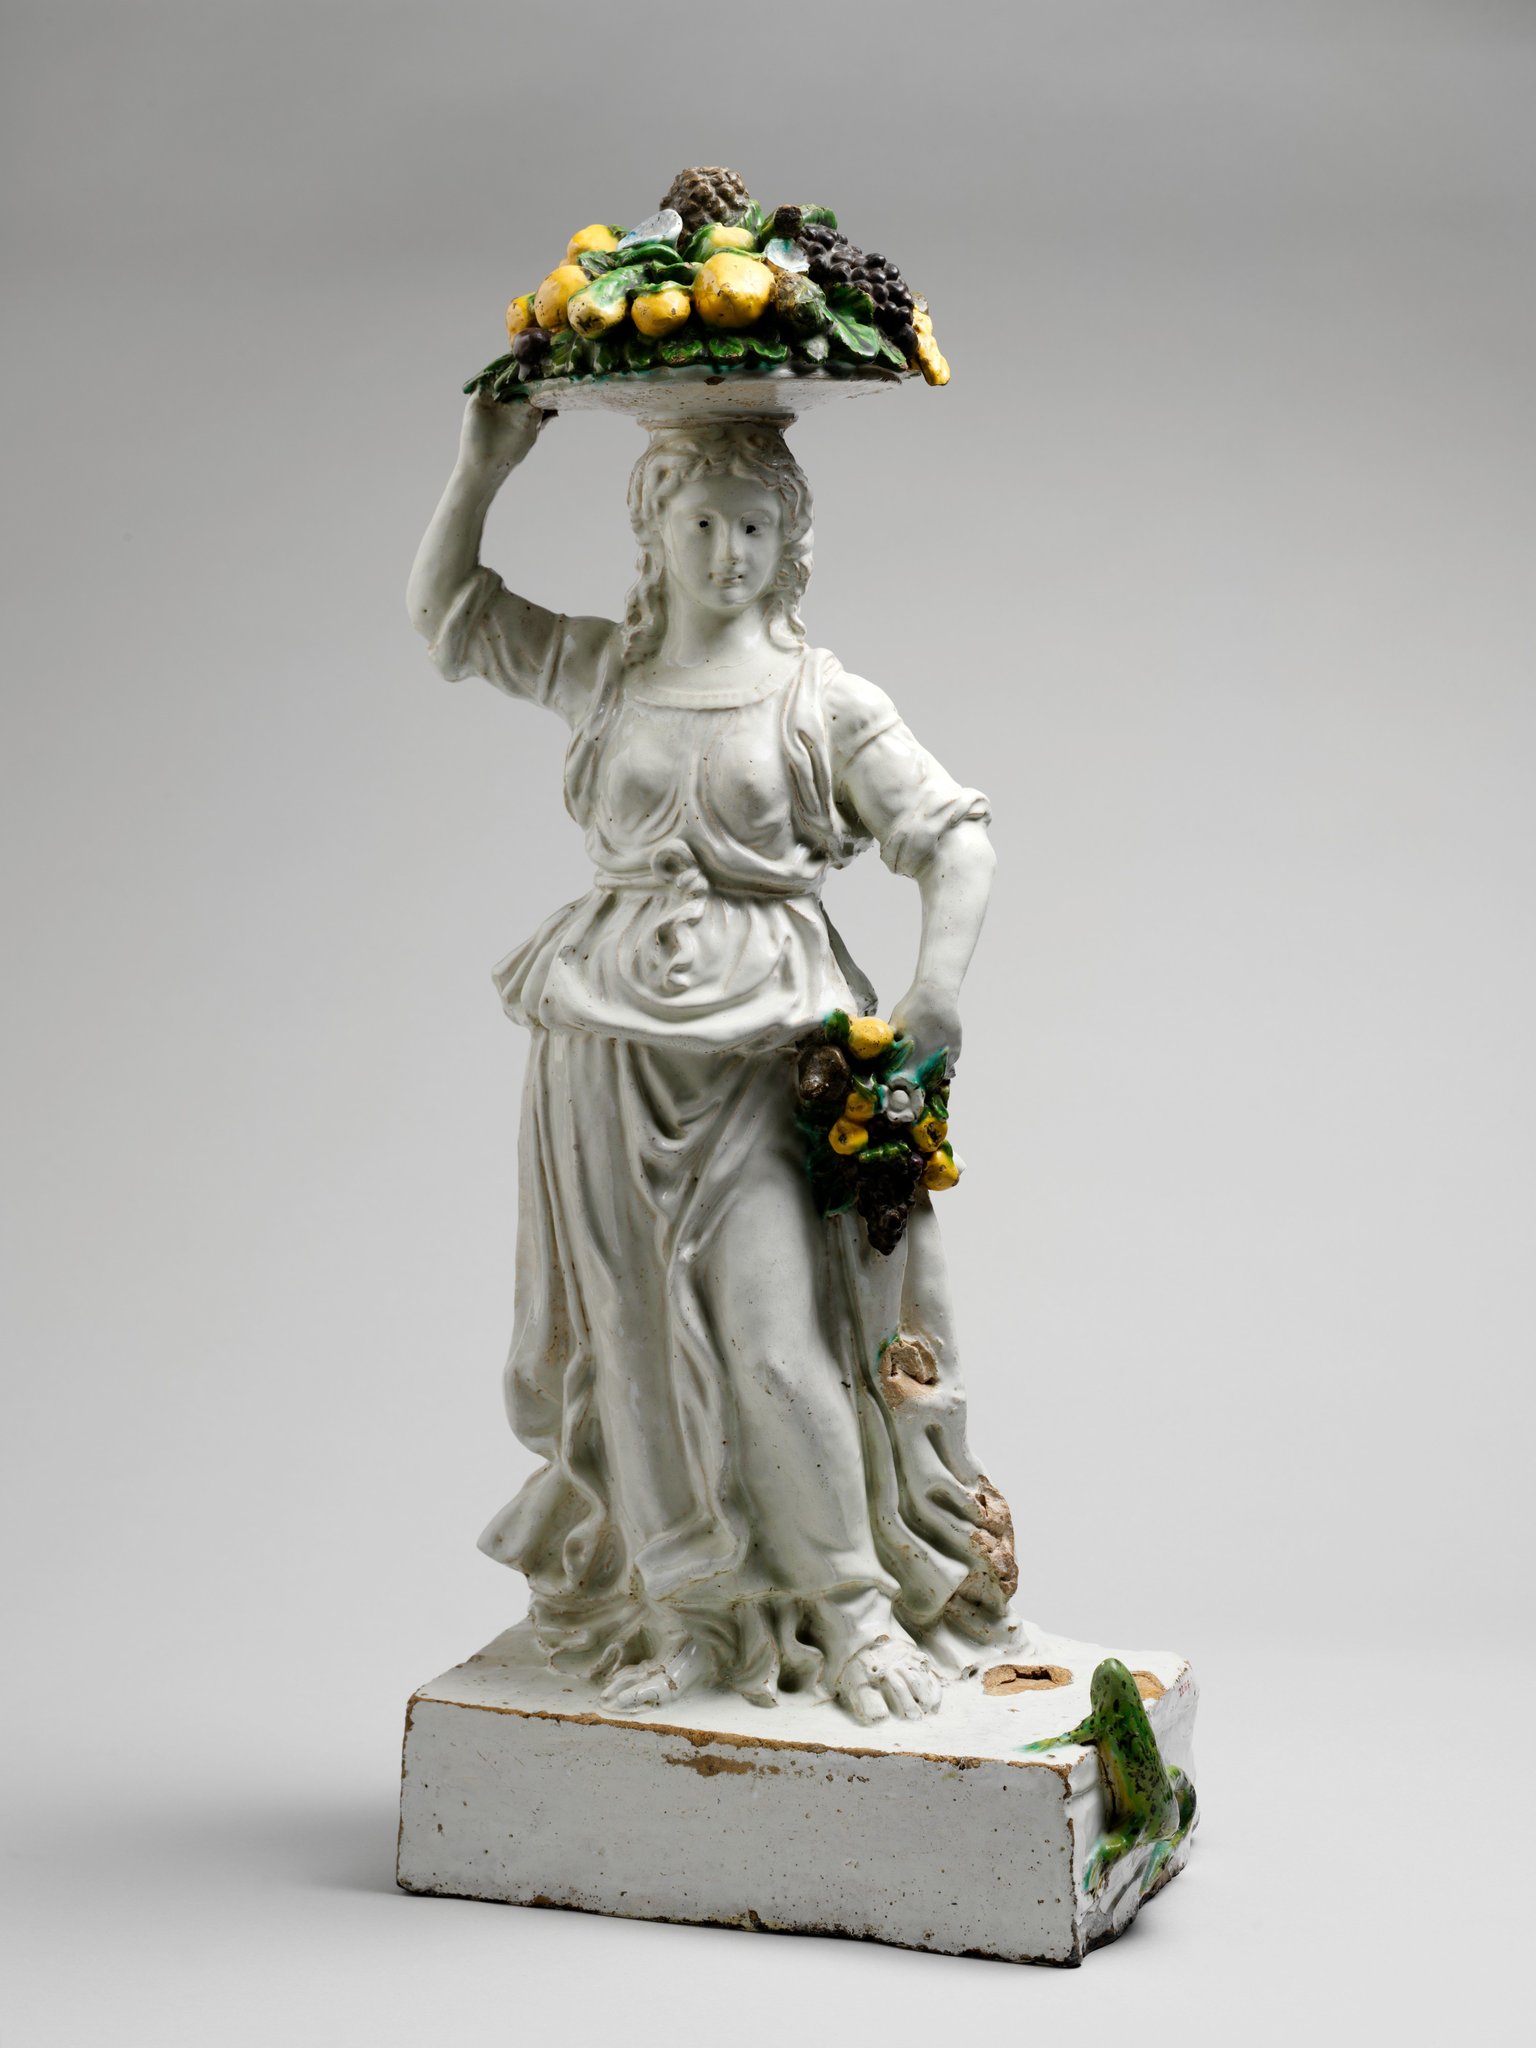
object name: statuette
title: Dovizia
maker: giovanni della robbia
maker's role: maker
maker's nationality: italian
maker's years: 1469-1530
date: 1467-1533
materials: terracotta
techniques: glazing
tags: fruit,women,frogs